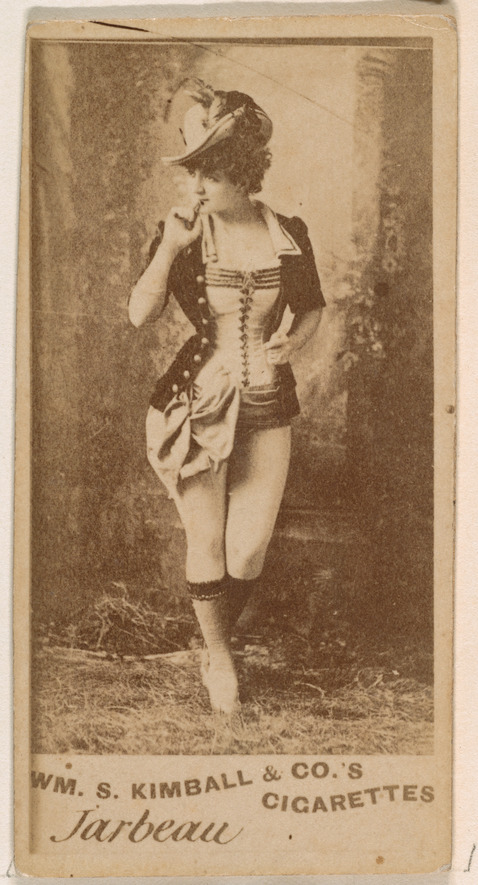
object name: photograph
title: Miss Jarbeau, from the Actresses series (N203) issued by Wm. S. Kimball & Co.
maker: william s. kimball & company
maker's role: publisher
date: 1889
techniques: color lithograph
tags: portraits,women,actresses